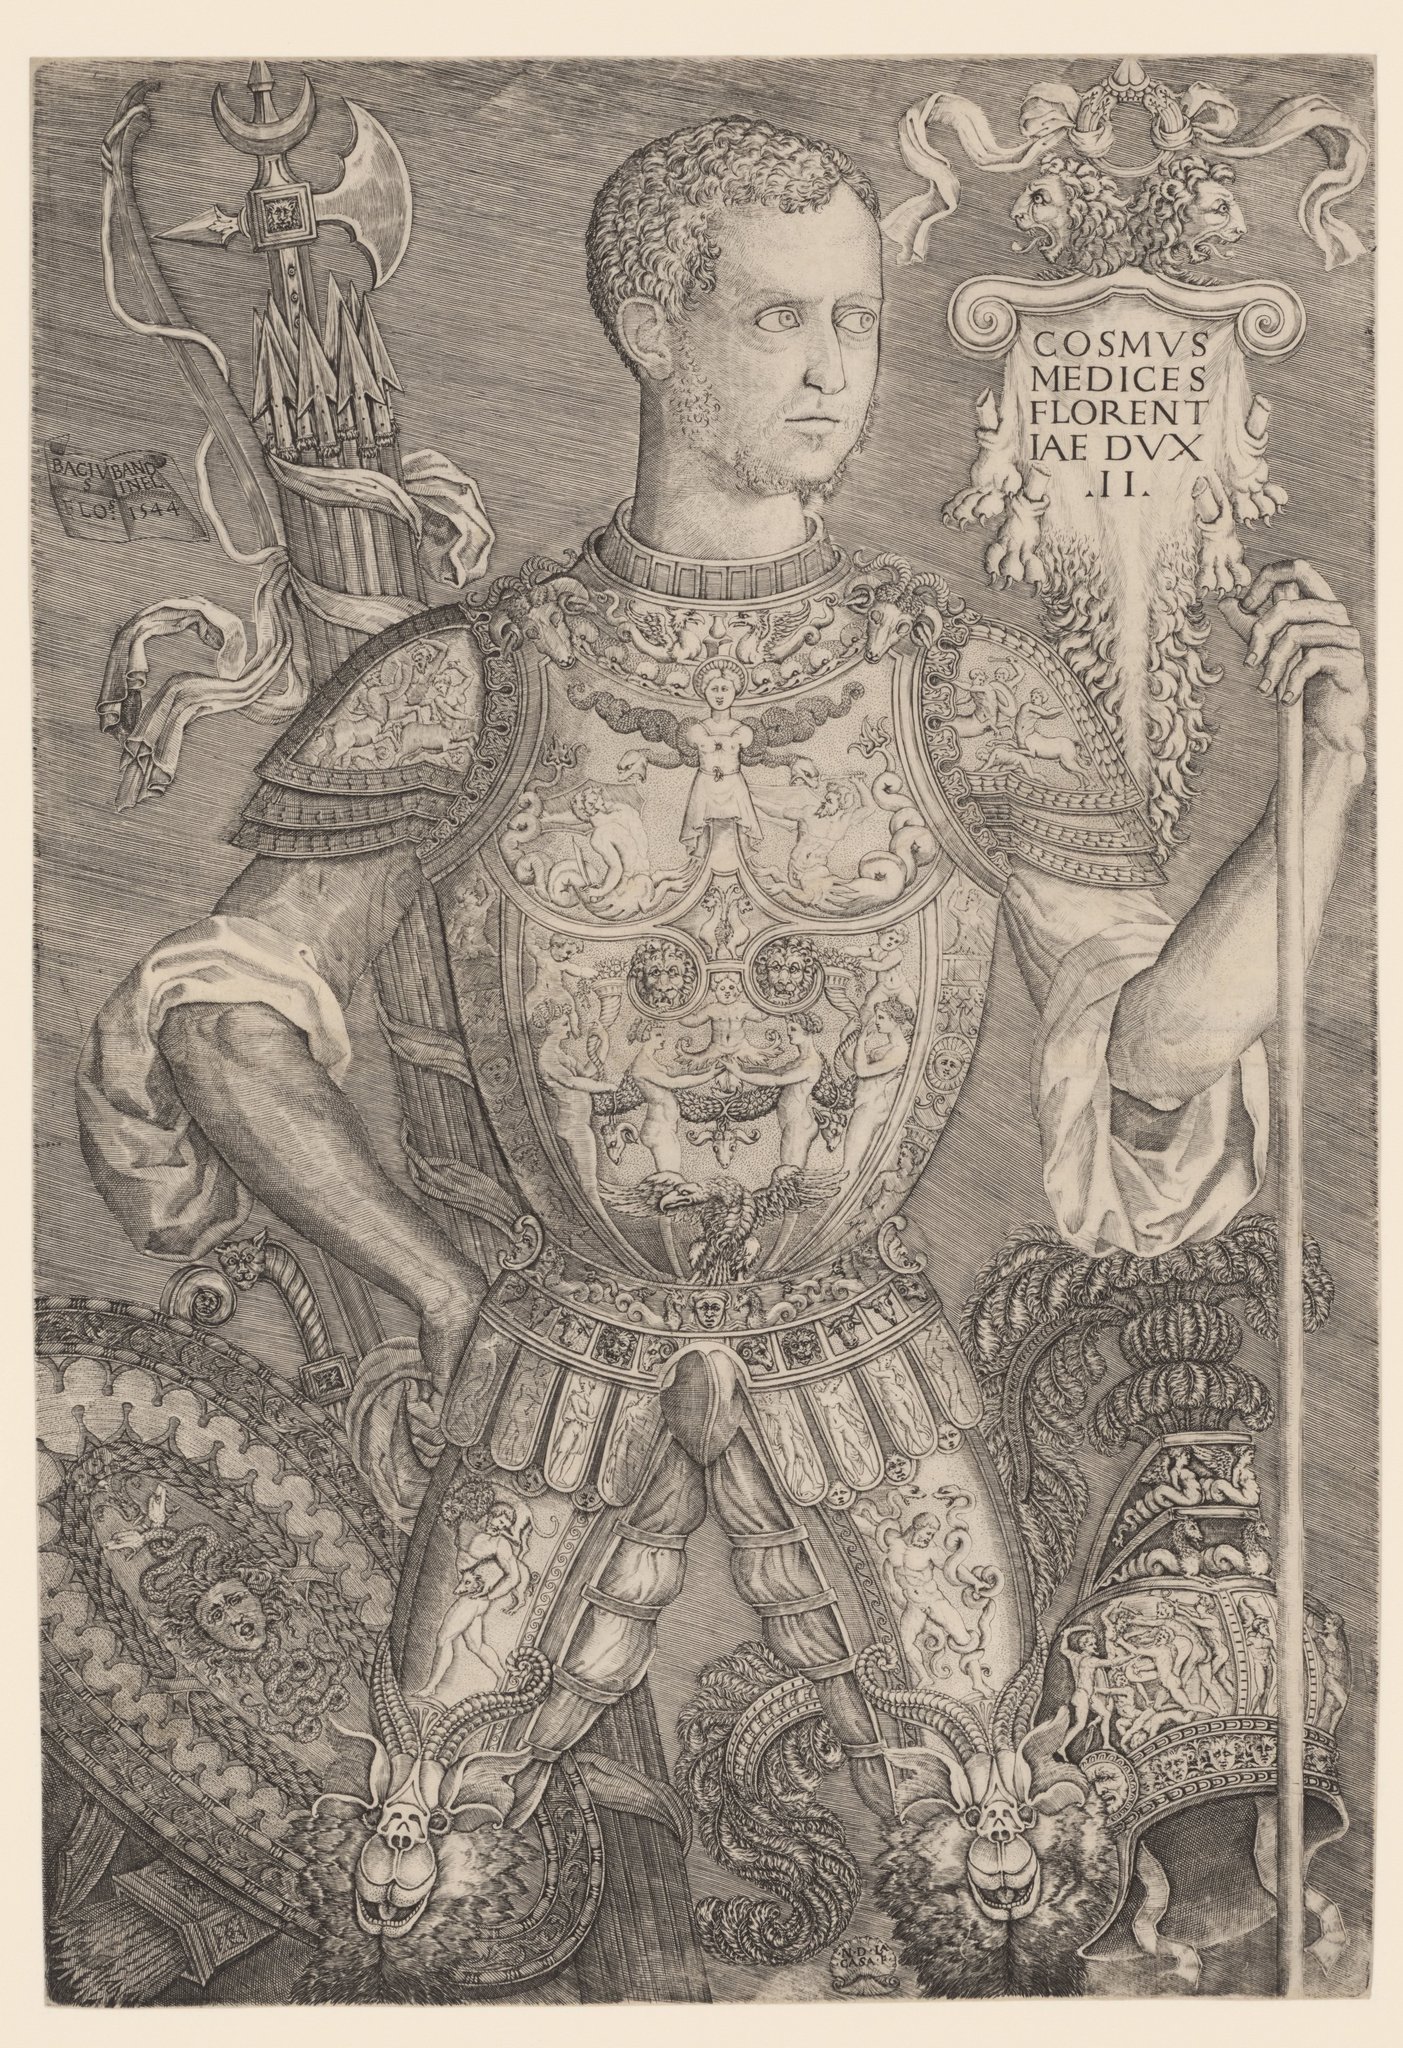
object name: print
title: Portret van Cosimo de'Medici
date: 1544-1552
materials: paper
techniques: engraving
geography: italy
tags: politician, (story of) hercules (heracles), armour, historical persons, gorgoneion, head of medusa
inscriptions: collector's mark: Lugt 2228